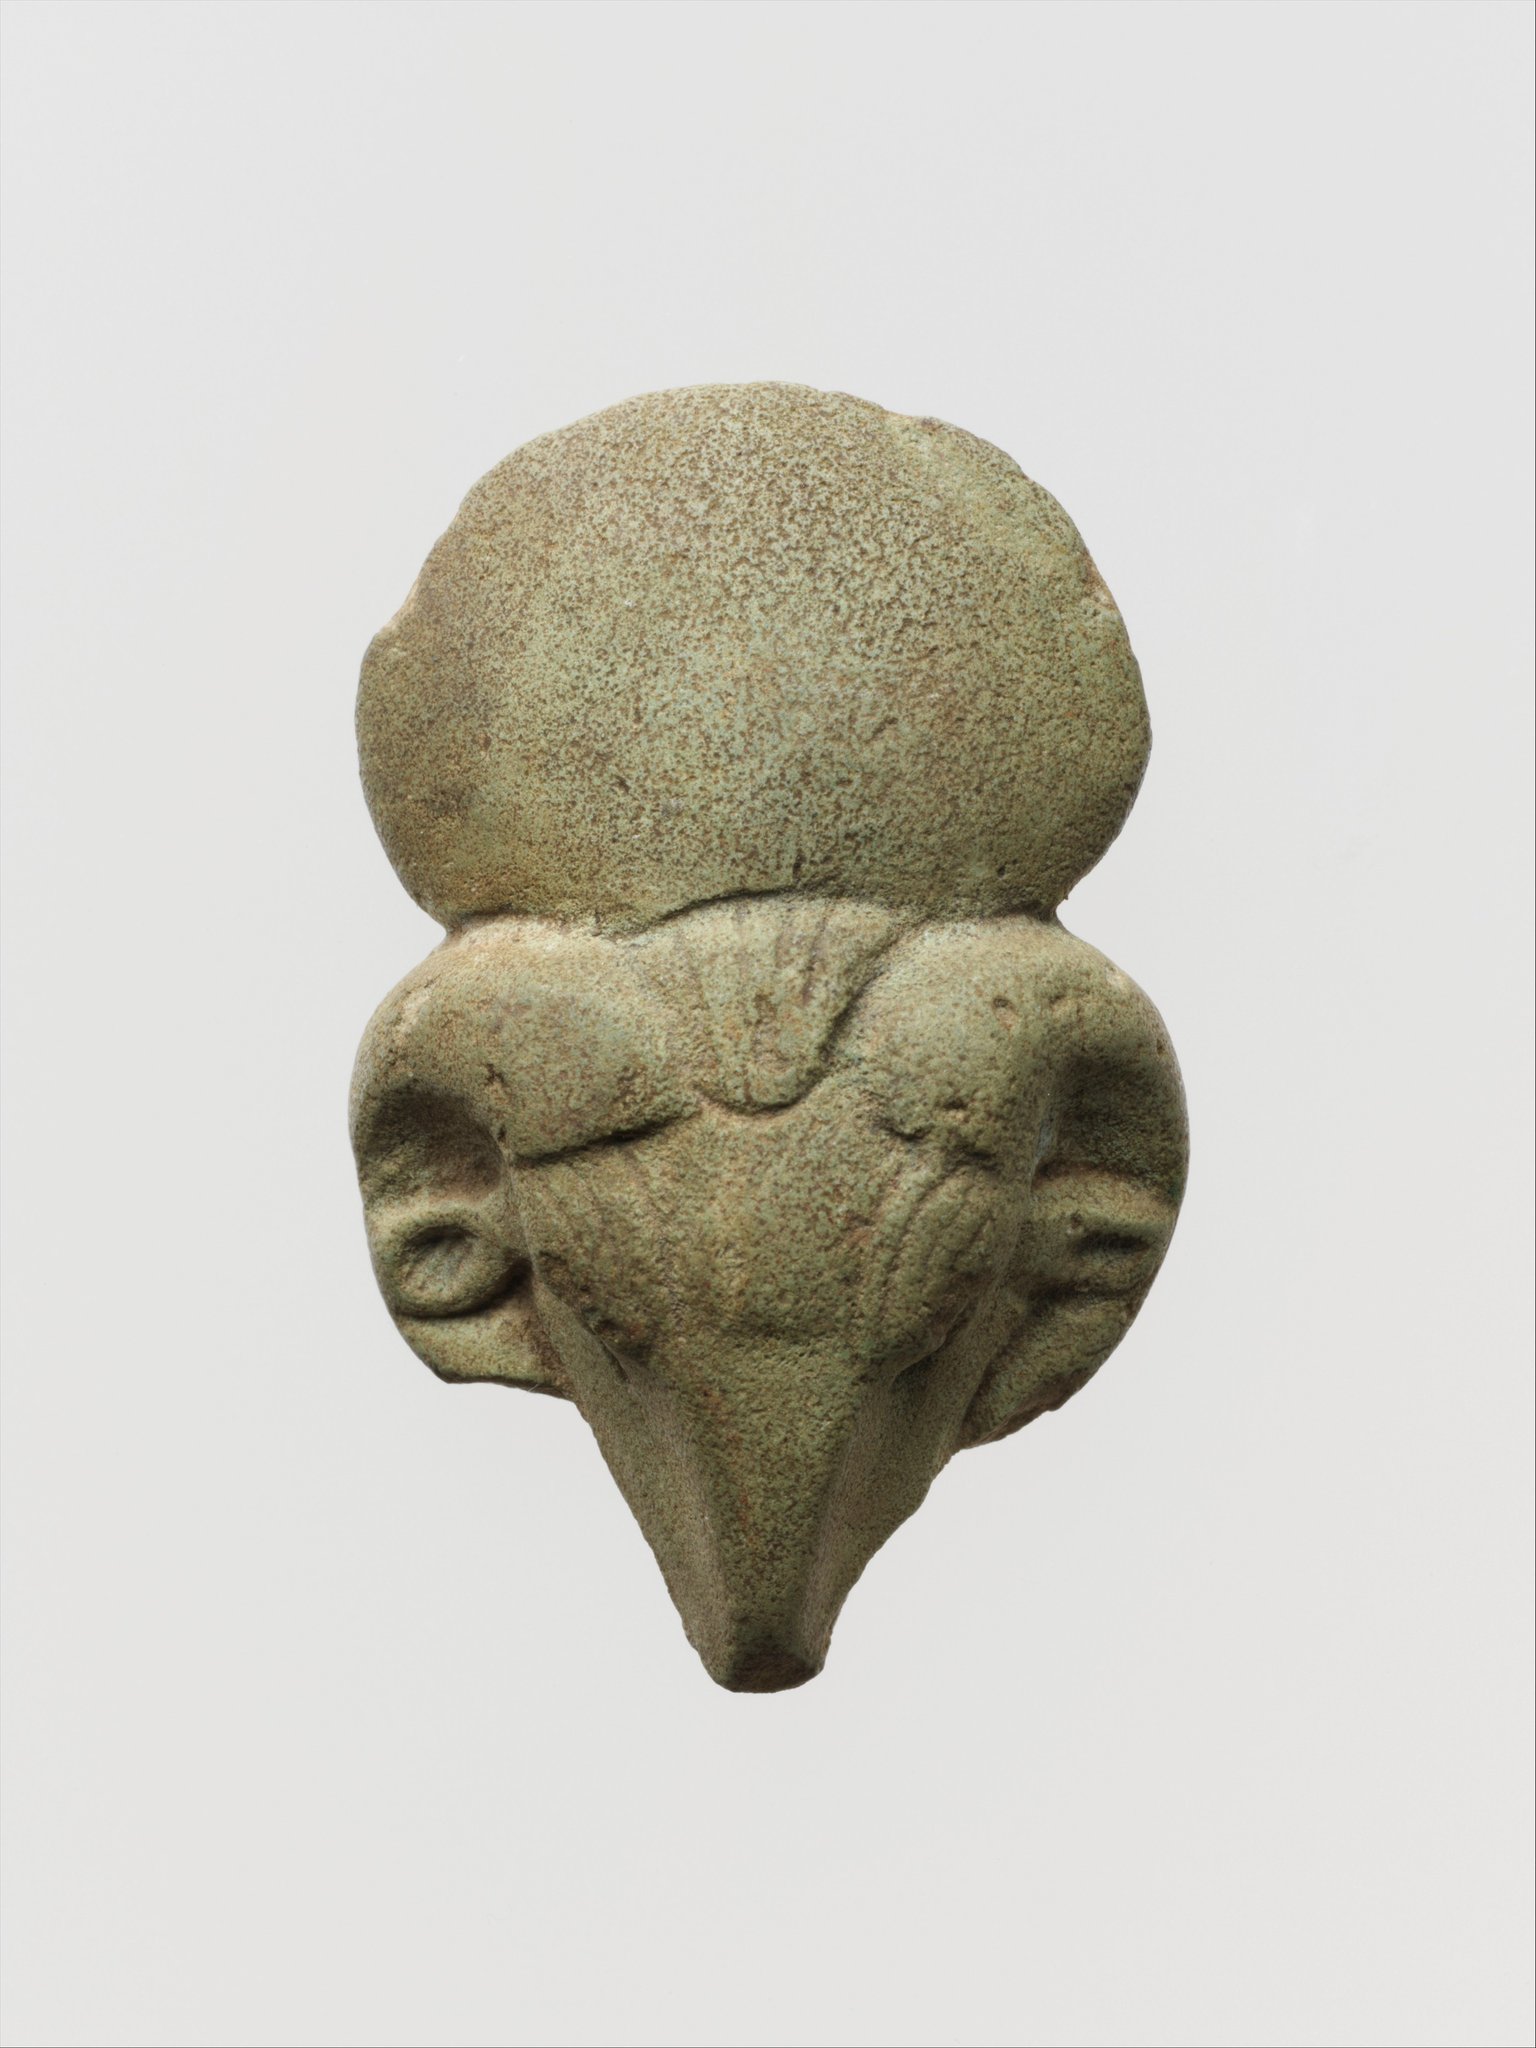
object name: amulet, ram's head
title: Faience amulet of a ram's head with sun disk crown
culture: egyptian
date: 664-334 BCE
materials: clay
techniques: glazing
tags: rams